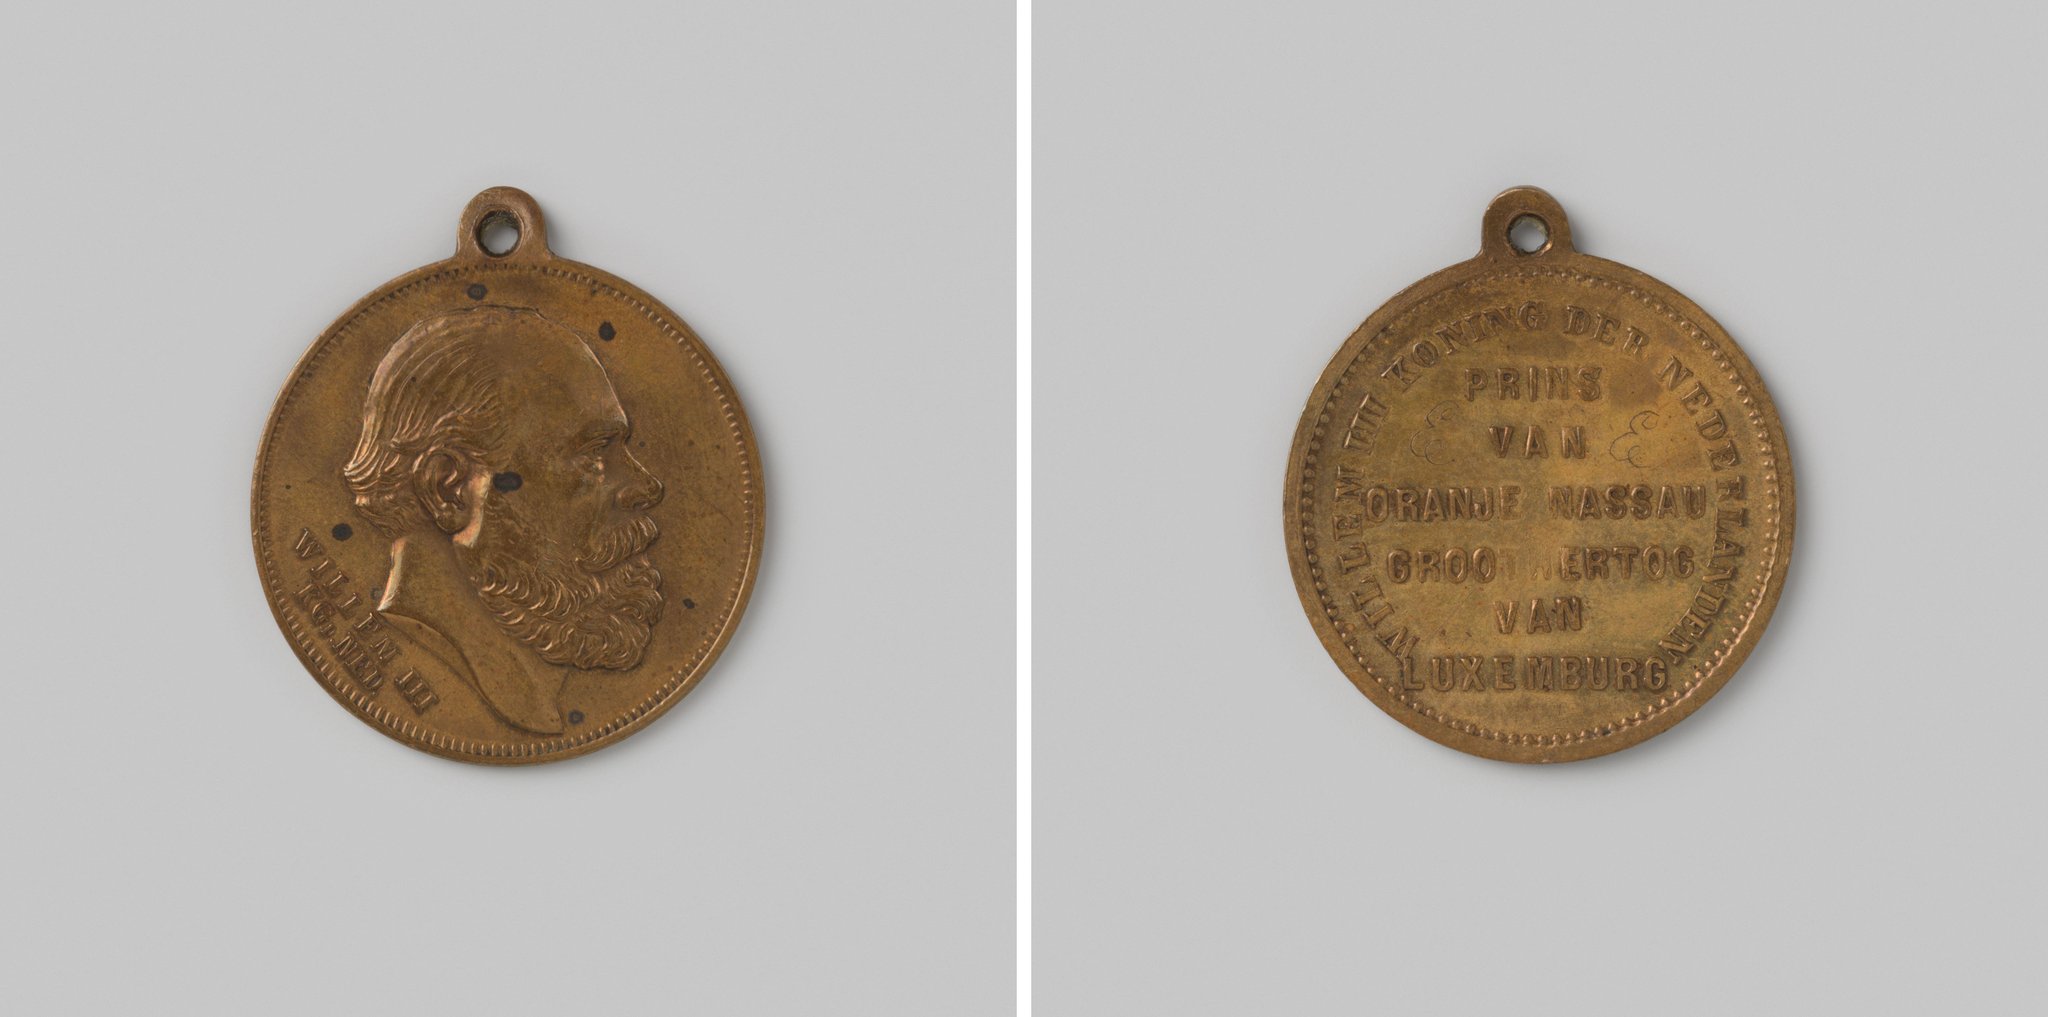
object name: history medal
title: Overlijden van Koning Willem III 1890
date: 1890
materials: brass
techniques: striking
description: Messing penning met draagoog, op de voorzijde het portret van Koning Willem III, tekst schuin achter zijn hoofd, op de keerzijde zes regels tekst met omschrift.